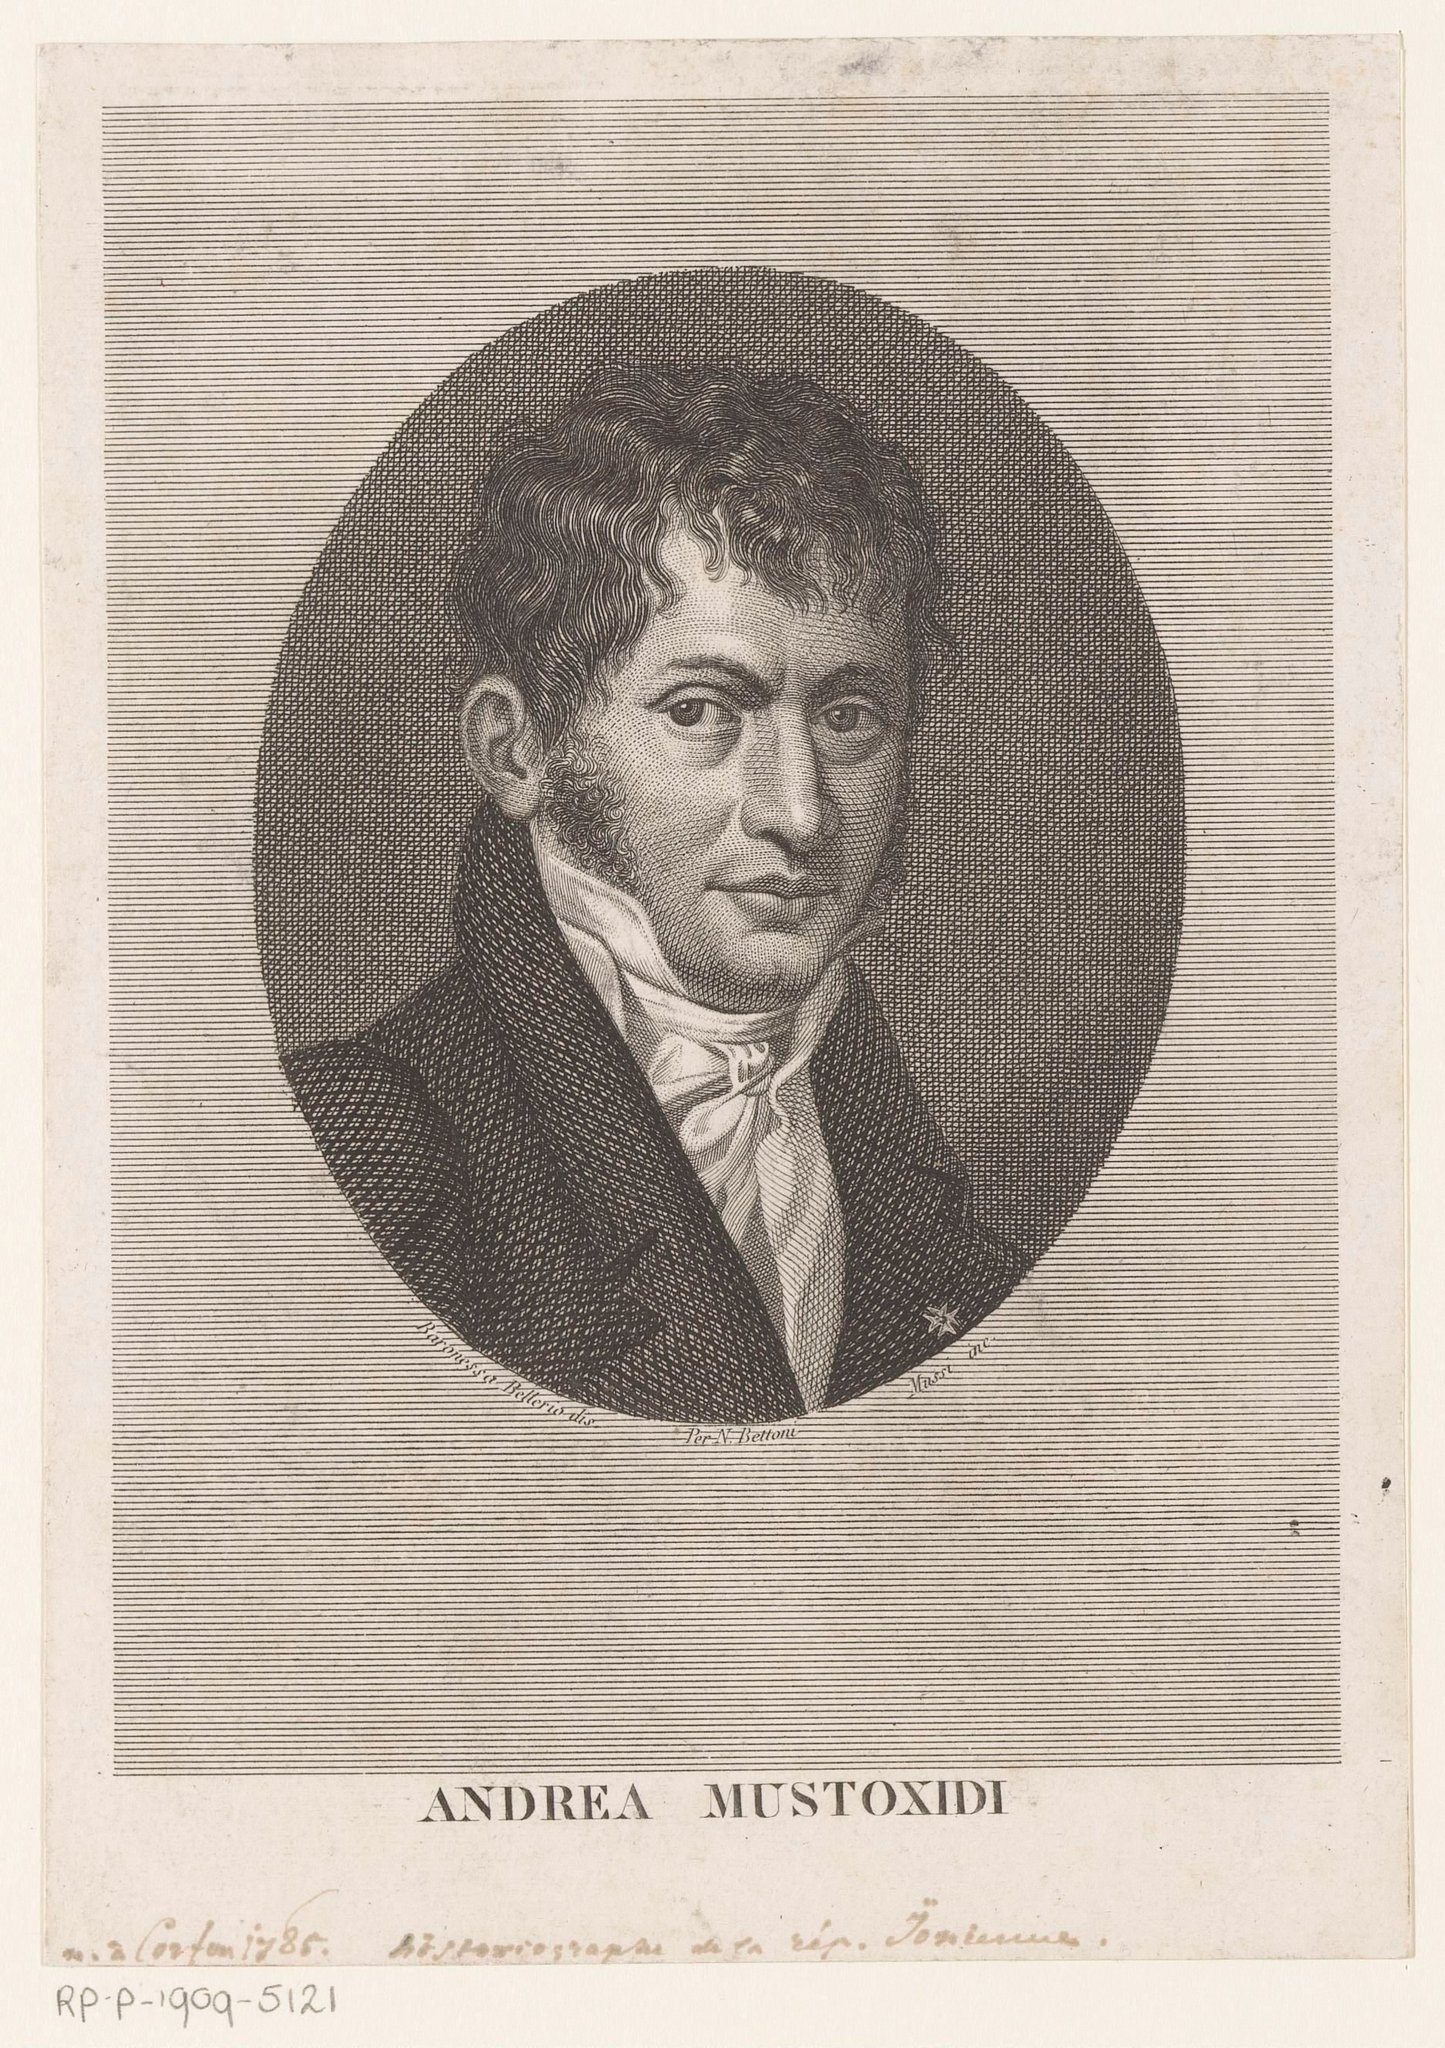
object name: print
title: Portret van historicus en filoloog Andrea Mustoxidi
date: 1875-1909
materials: paper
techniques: engraving, etching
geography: italy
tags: historical persons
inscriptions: inscription: ‘[...] Corfu 1785. [...]’, collector's mark: Lugt 2228